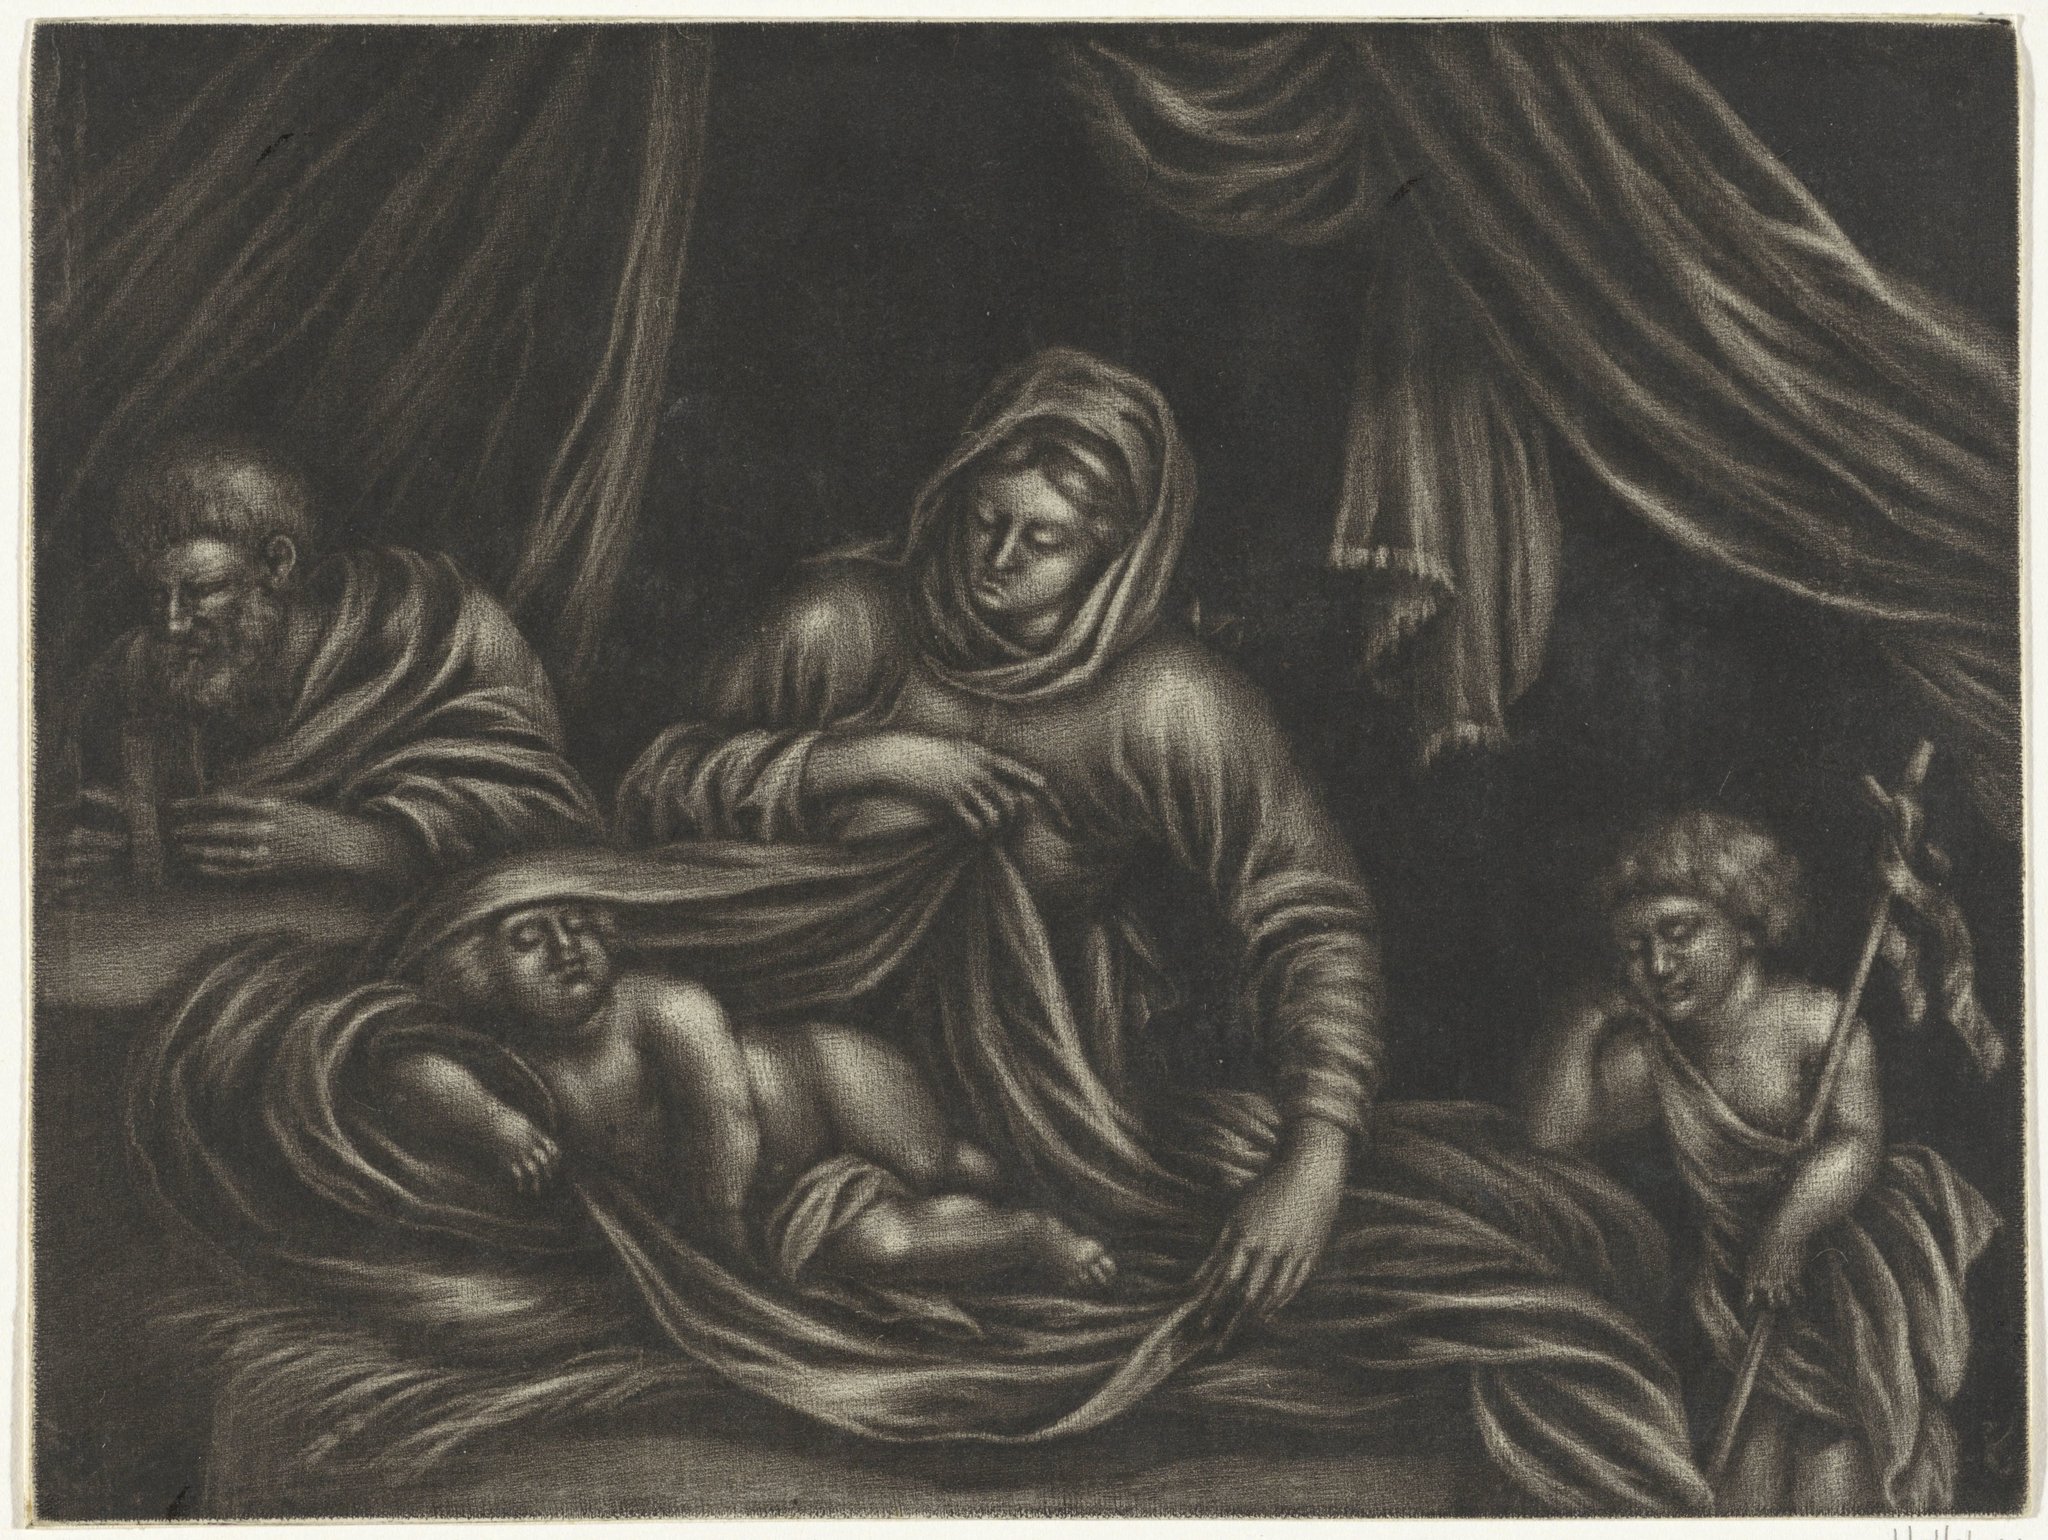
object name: print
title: Heilige Familie met Johannes de Doper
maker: jan van somer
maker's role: draughtsman, print maker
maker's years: 1645-1699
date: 1655-1700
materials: paper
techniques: mezzotint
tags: holy family with john the baptist (as child)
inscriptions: collector's mark: Lugt 2228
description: Maria toont het Christuskind terwijl Jozef een boek leest. Naast Maria staat de jonge Johannes de Doper.